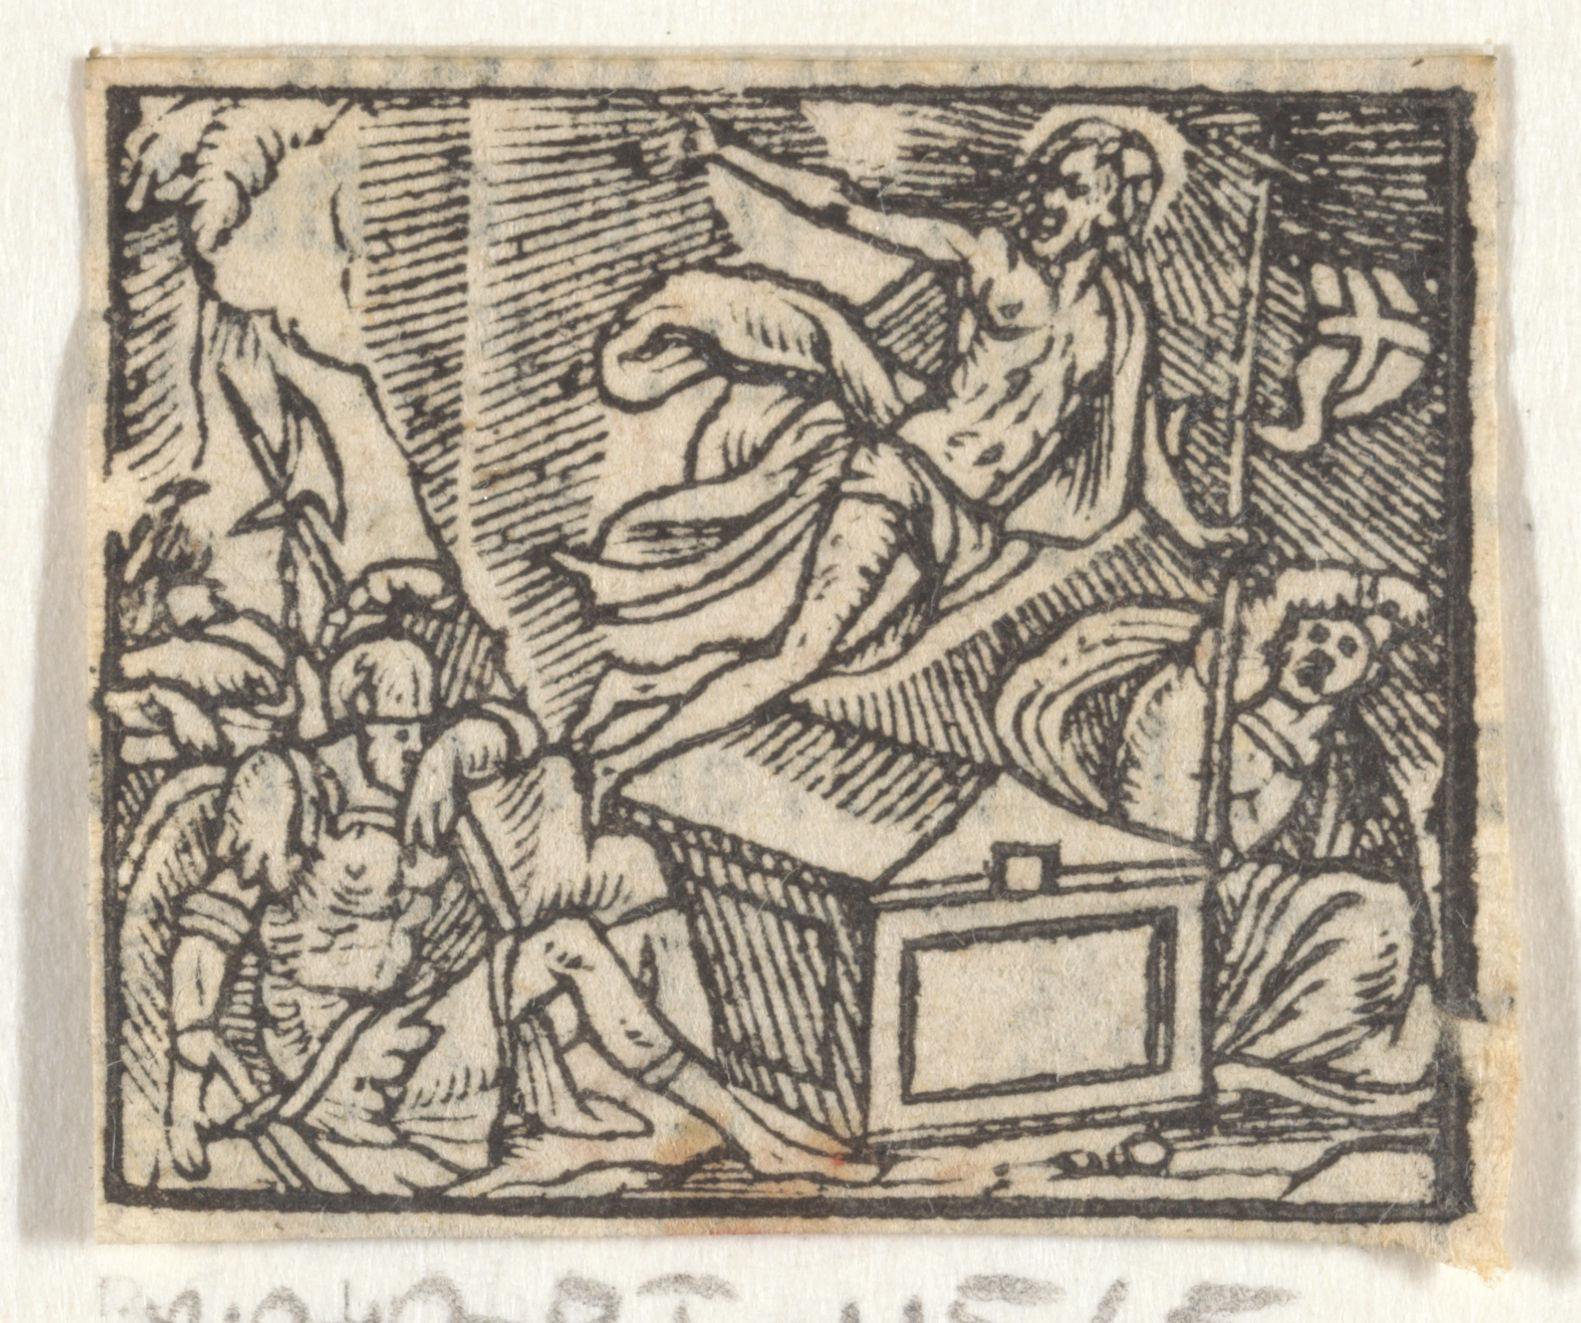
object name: print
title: Opstanding van Christus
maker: Anonymous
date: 1600-1699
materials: paper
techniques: letterpress printing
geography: netherlands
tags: christ, usually holding a banner, arises from the grave; often combined with sleeping and/or frightened soldiers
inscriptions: collector's mark: Lugt 240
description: Christus zweeft boven de sarcofaag. De soldaten die rondom het graf liggen schrikken wakker.